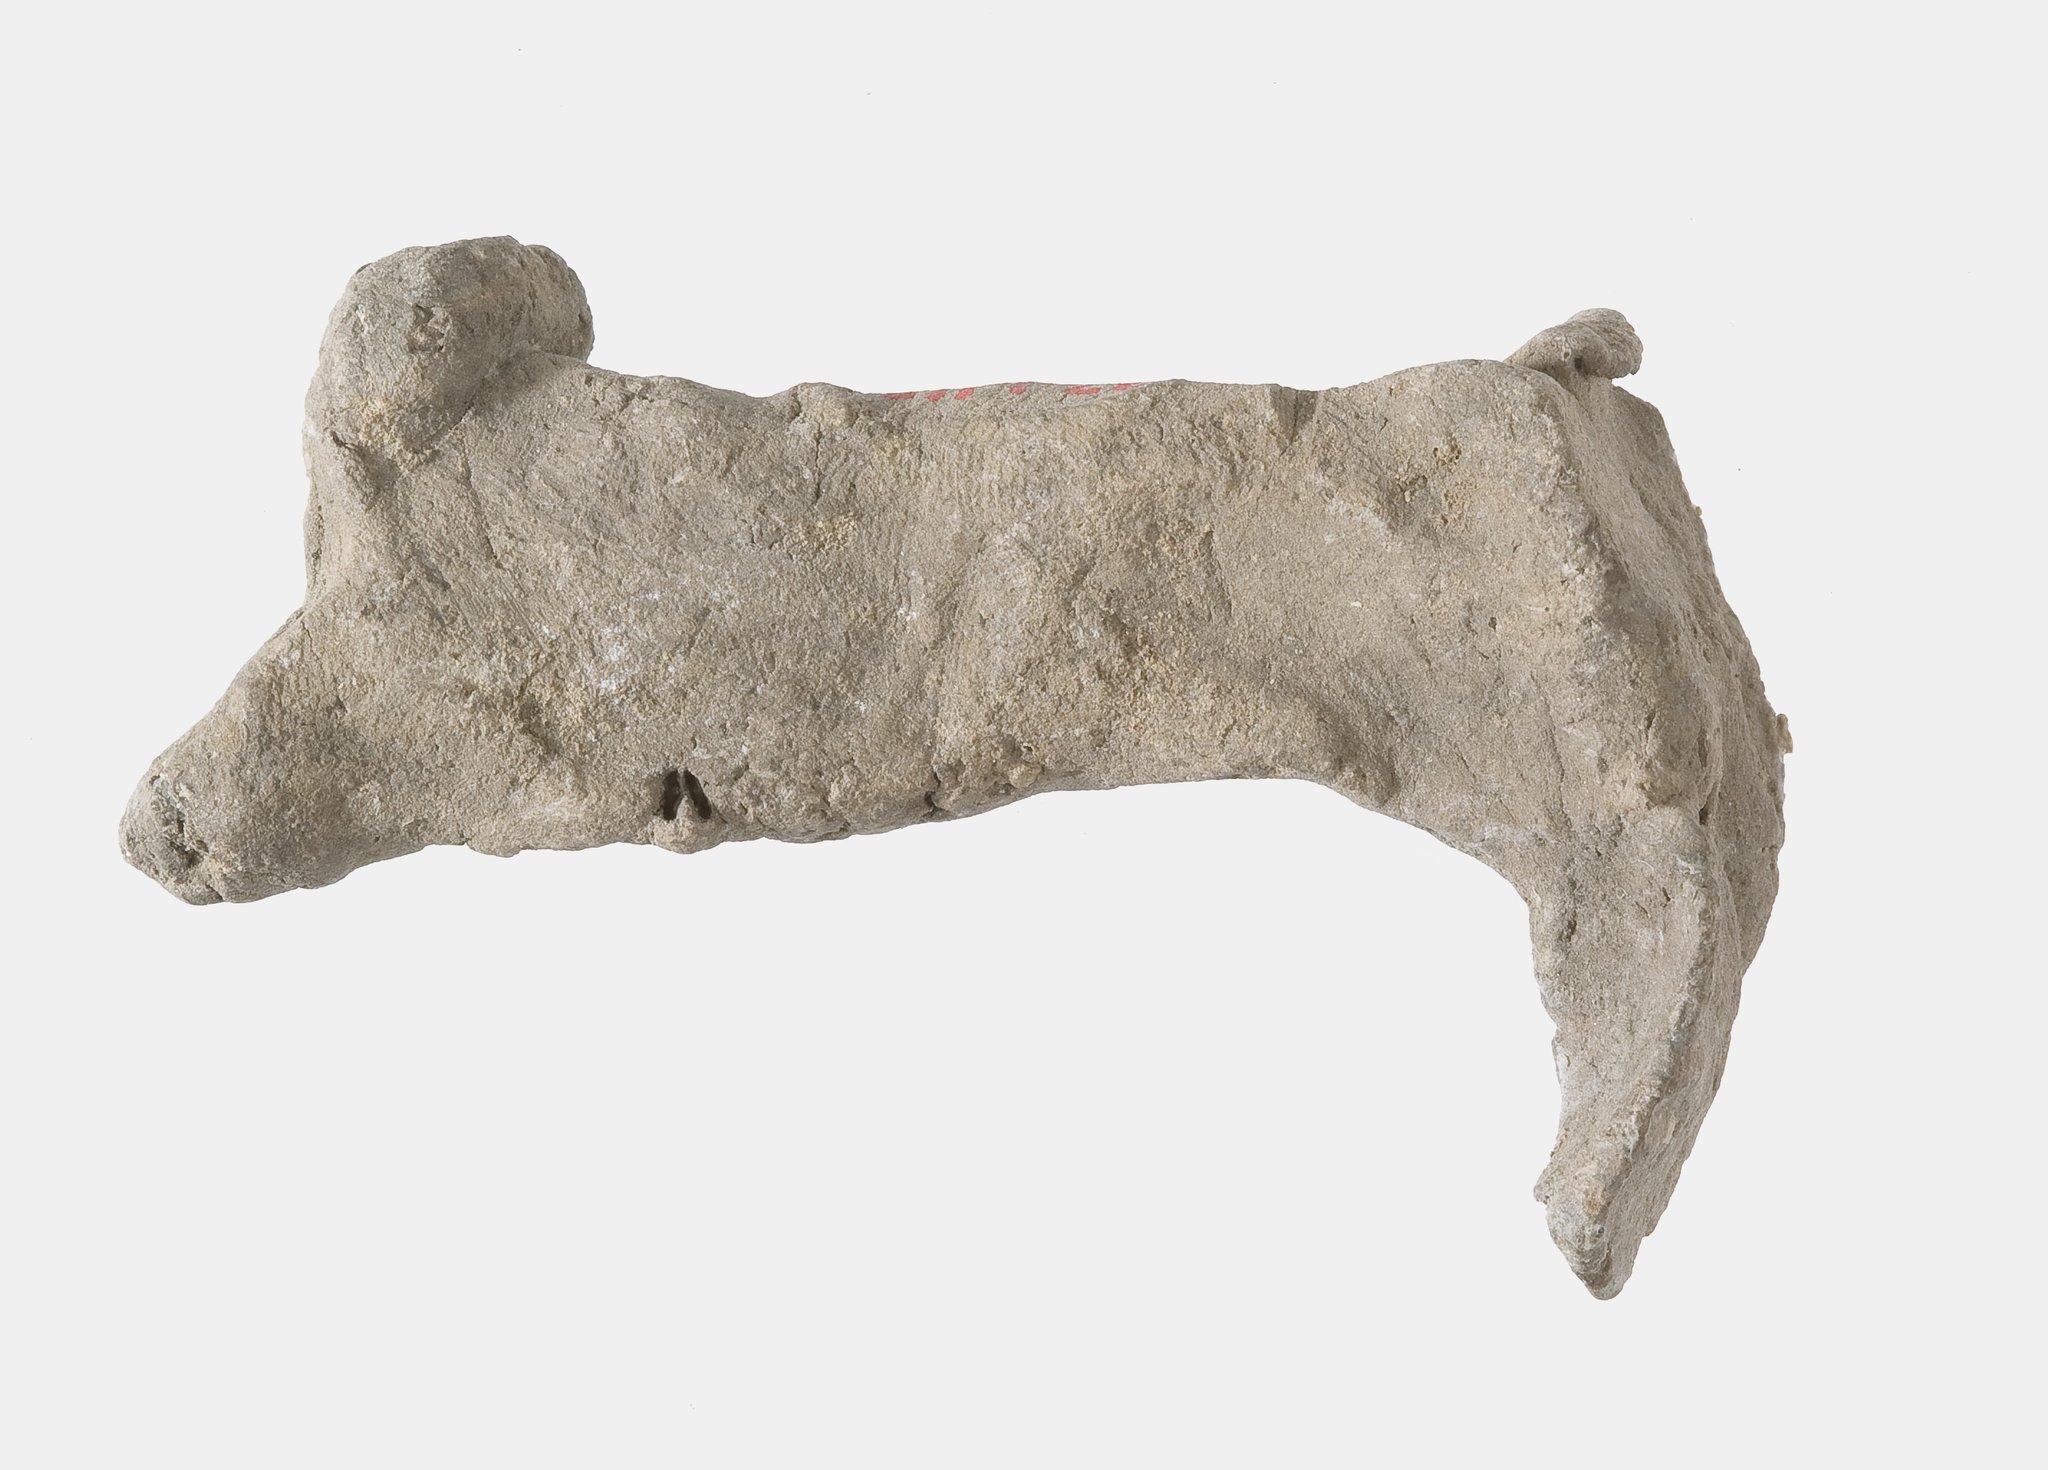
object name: sealing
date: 1850-1700 BCE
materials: mud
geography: egypt